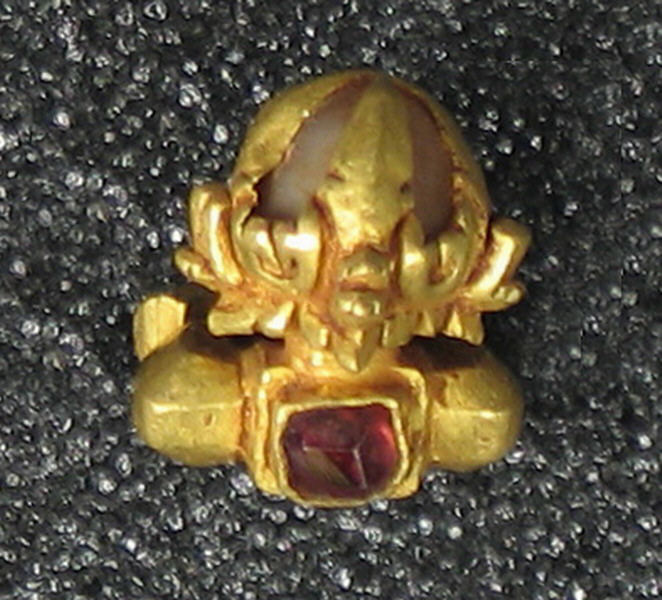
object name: earring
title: Cast Earring with Ruby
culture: indonesian, central java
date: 701-1200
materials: gold